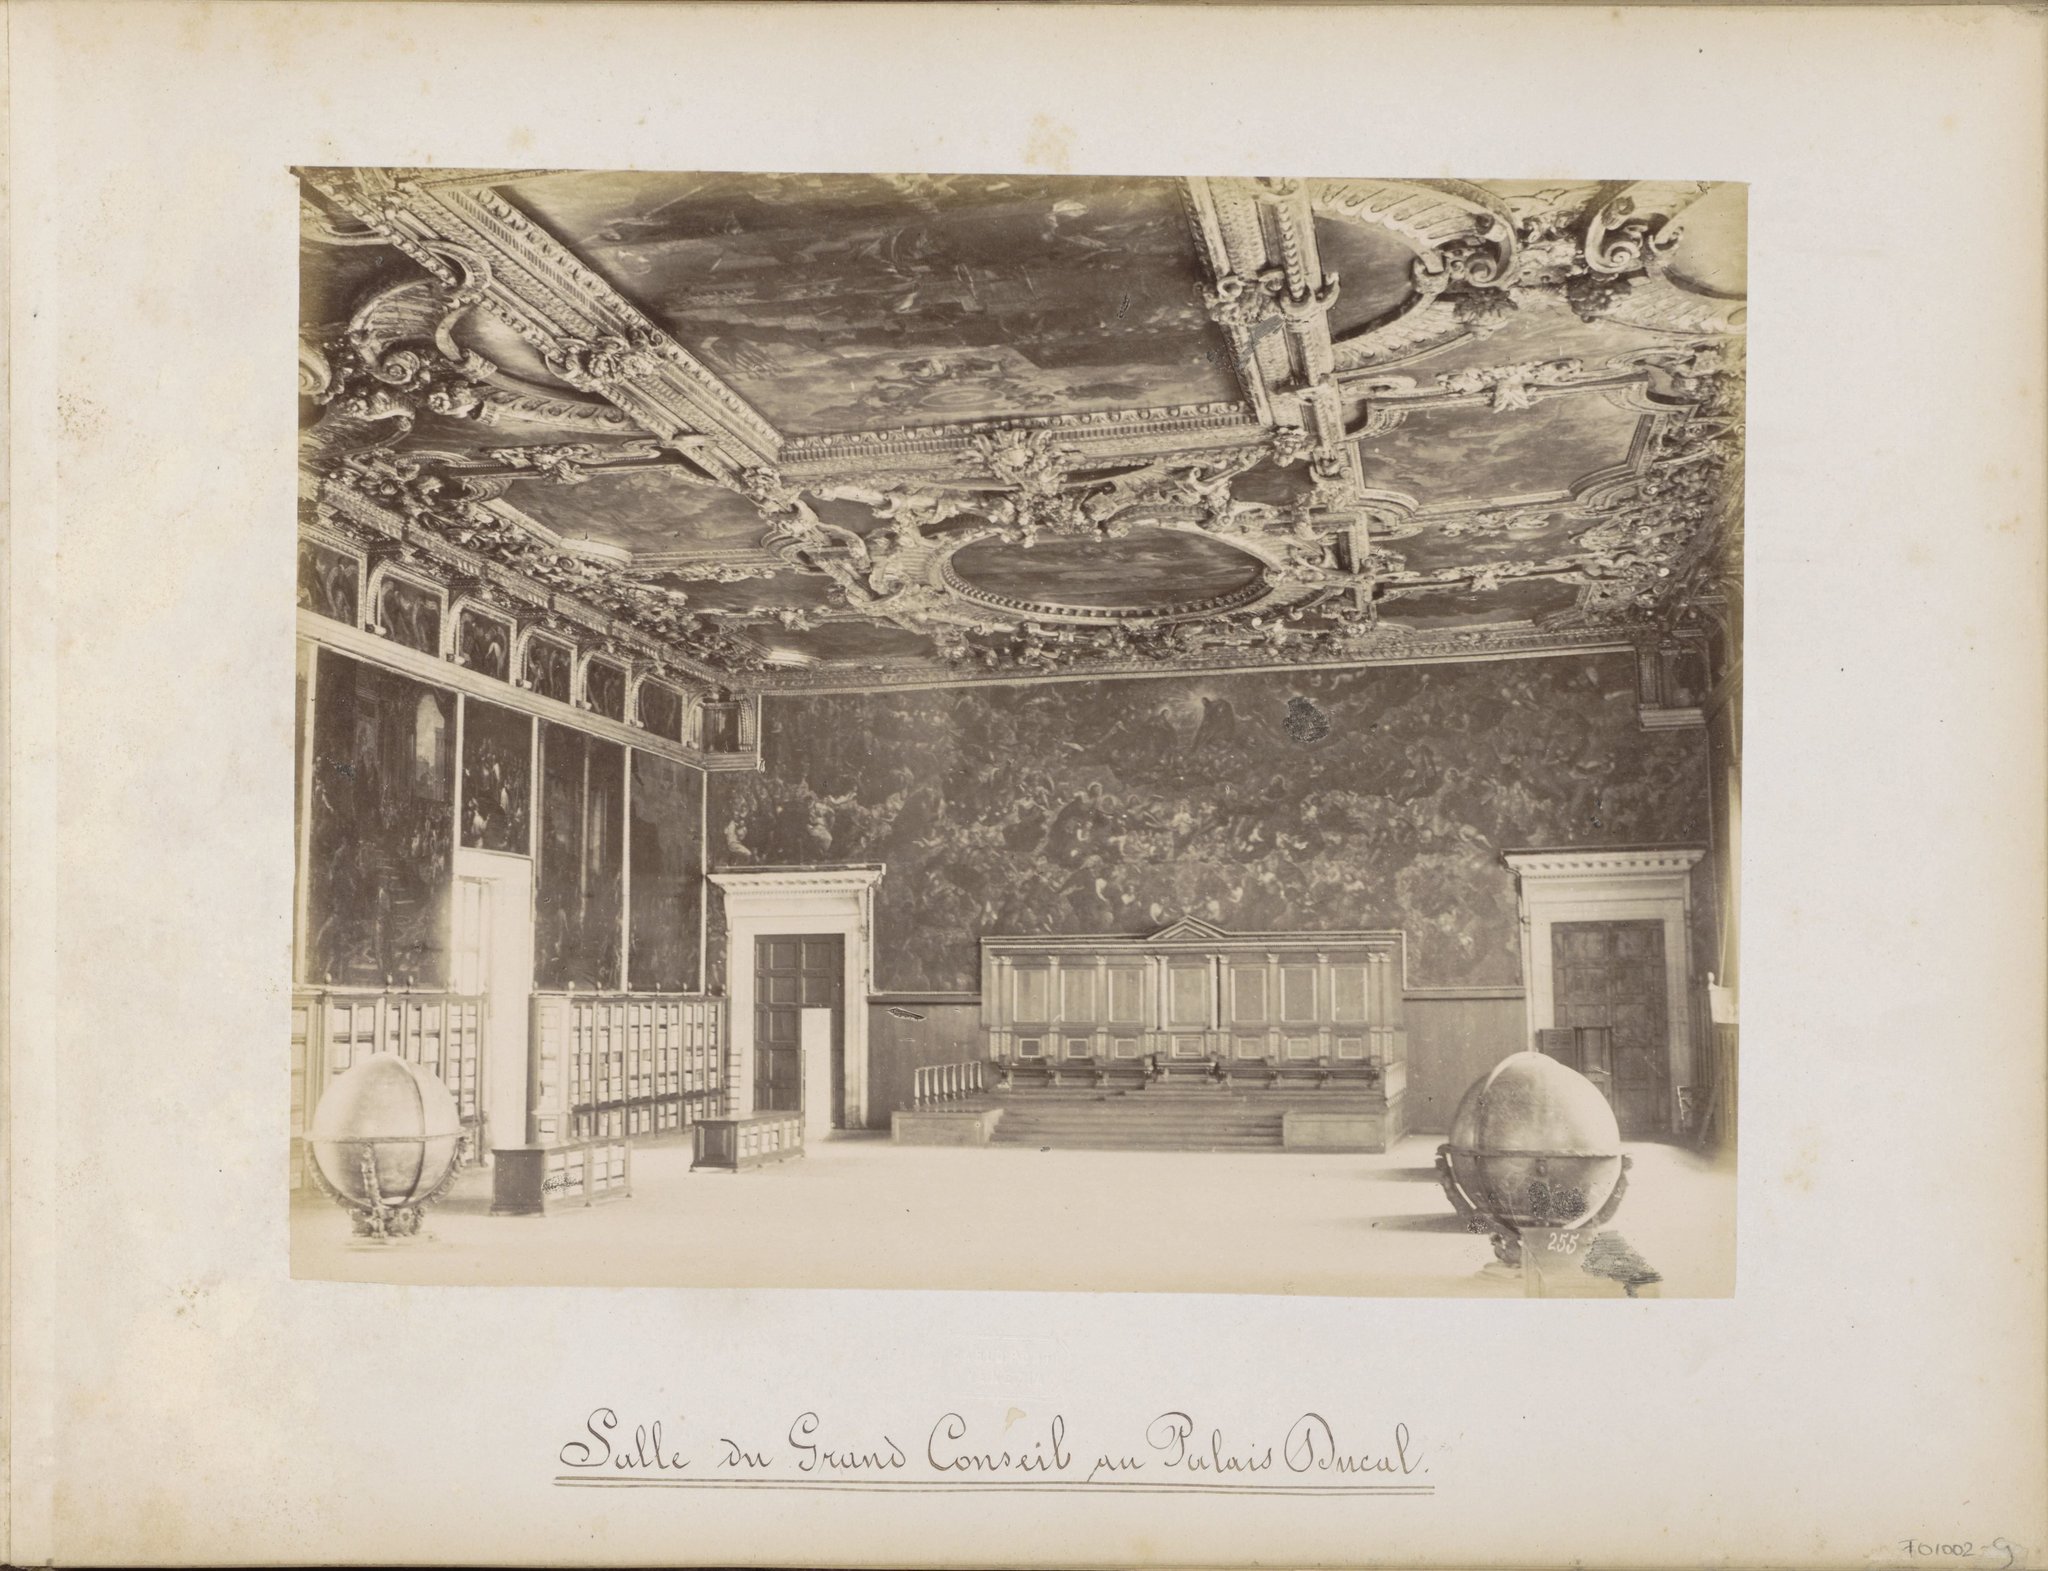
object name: photograph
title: Zaal van de Grote Raad in het Dogepaleis in Venetië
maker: carlo ponti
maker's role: fotograaf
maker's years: 1820-1893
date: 1860-1881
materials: photographic support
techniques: albumen print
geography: venice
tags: palace, (decorated) ceiling, globe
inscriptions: negative number: ‘255’, check stamp: ‘Carlo Ponti Venezia’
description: Onderdeel van Topografisch album van Venetië 1881.